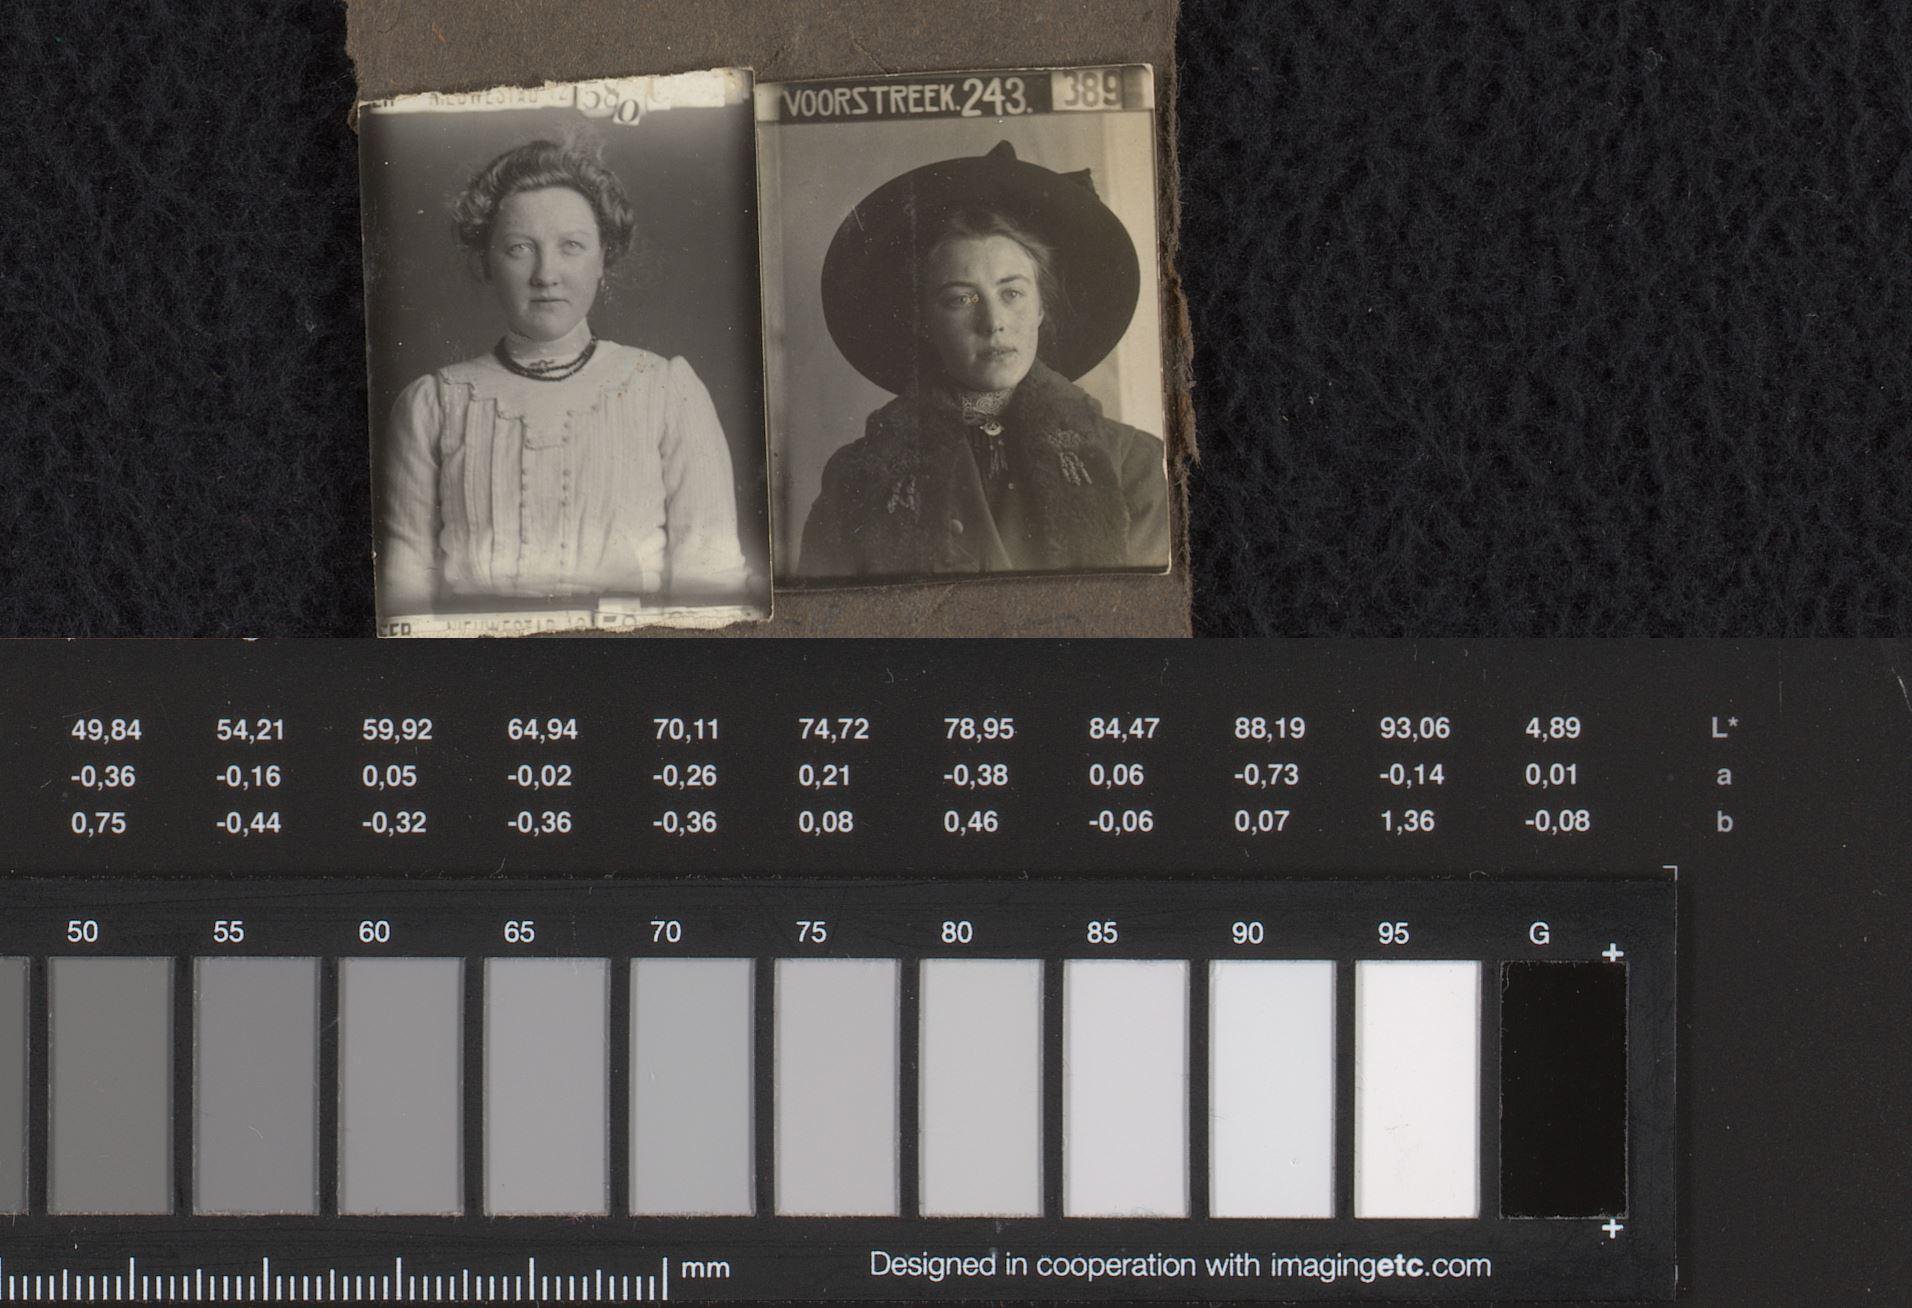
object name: album leaf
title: Portret van een onbekende jonge vrouw met hoed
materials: paper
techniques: gelatin silver print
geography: leeuwarden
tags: anonymous historical person portrayed - bb - woman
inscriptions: address: ‘VOORSTREEK. 243./ 389’